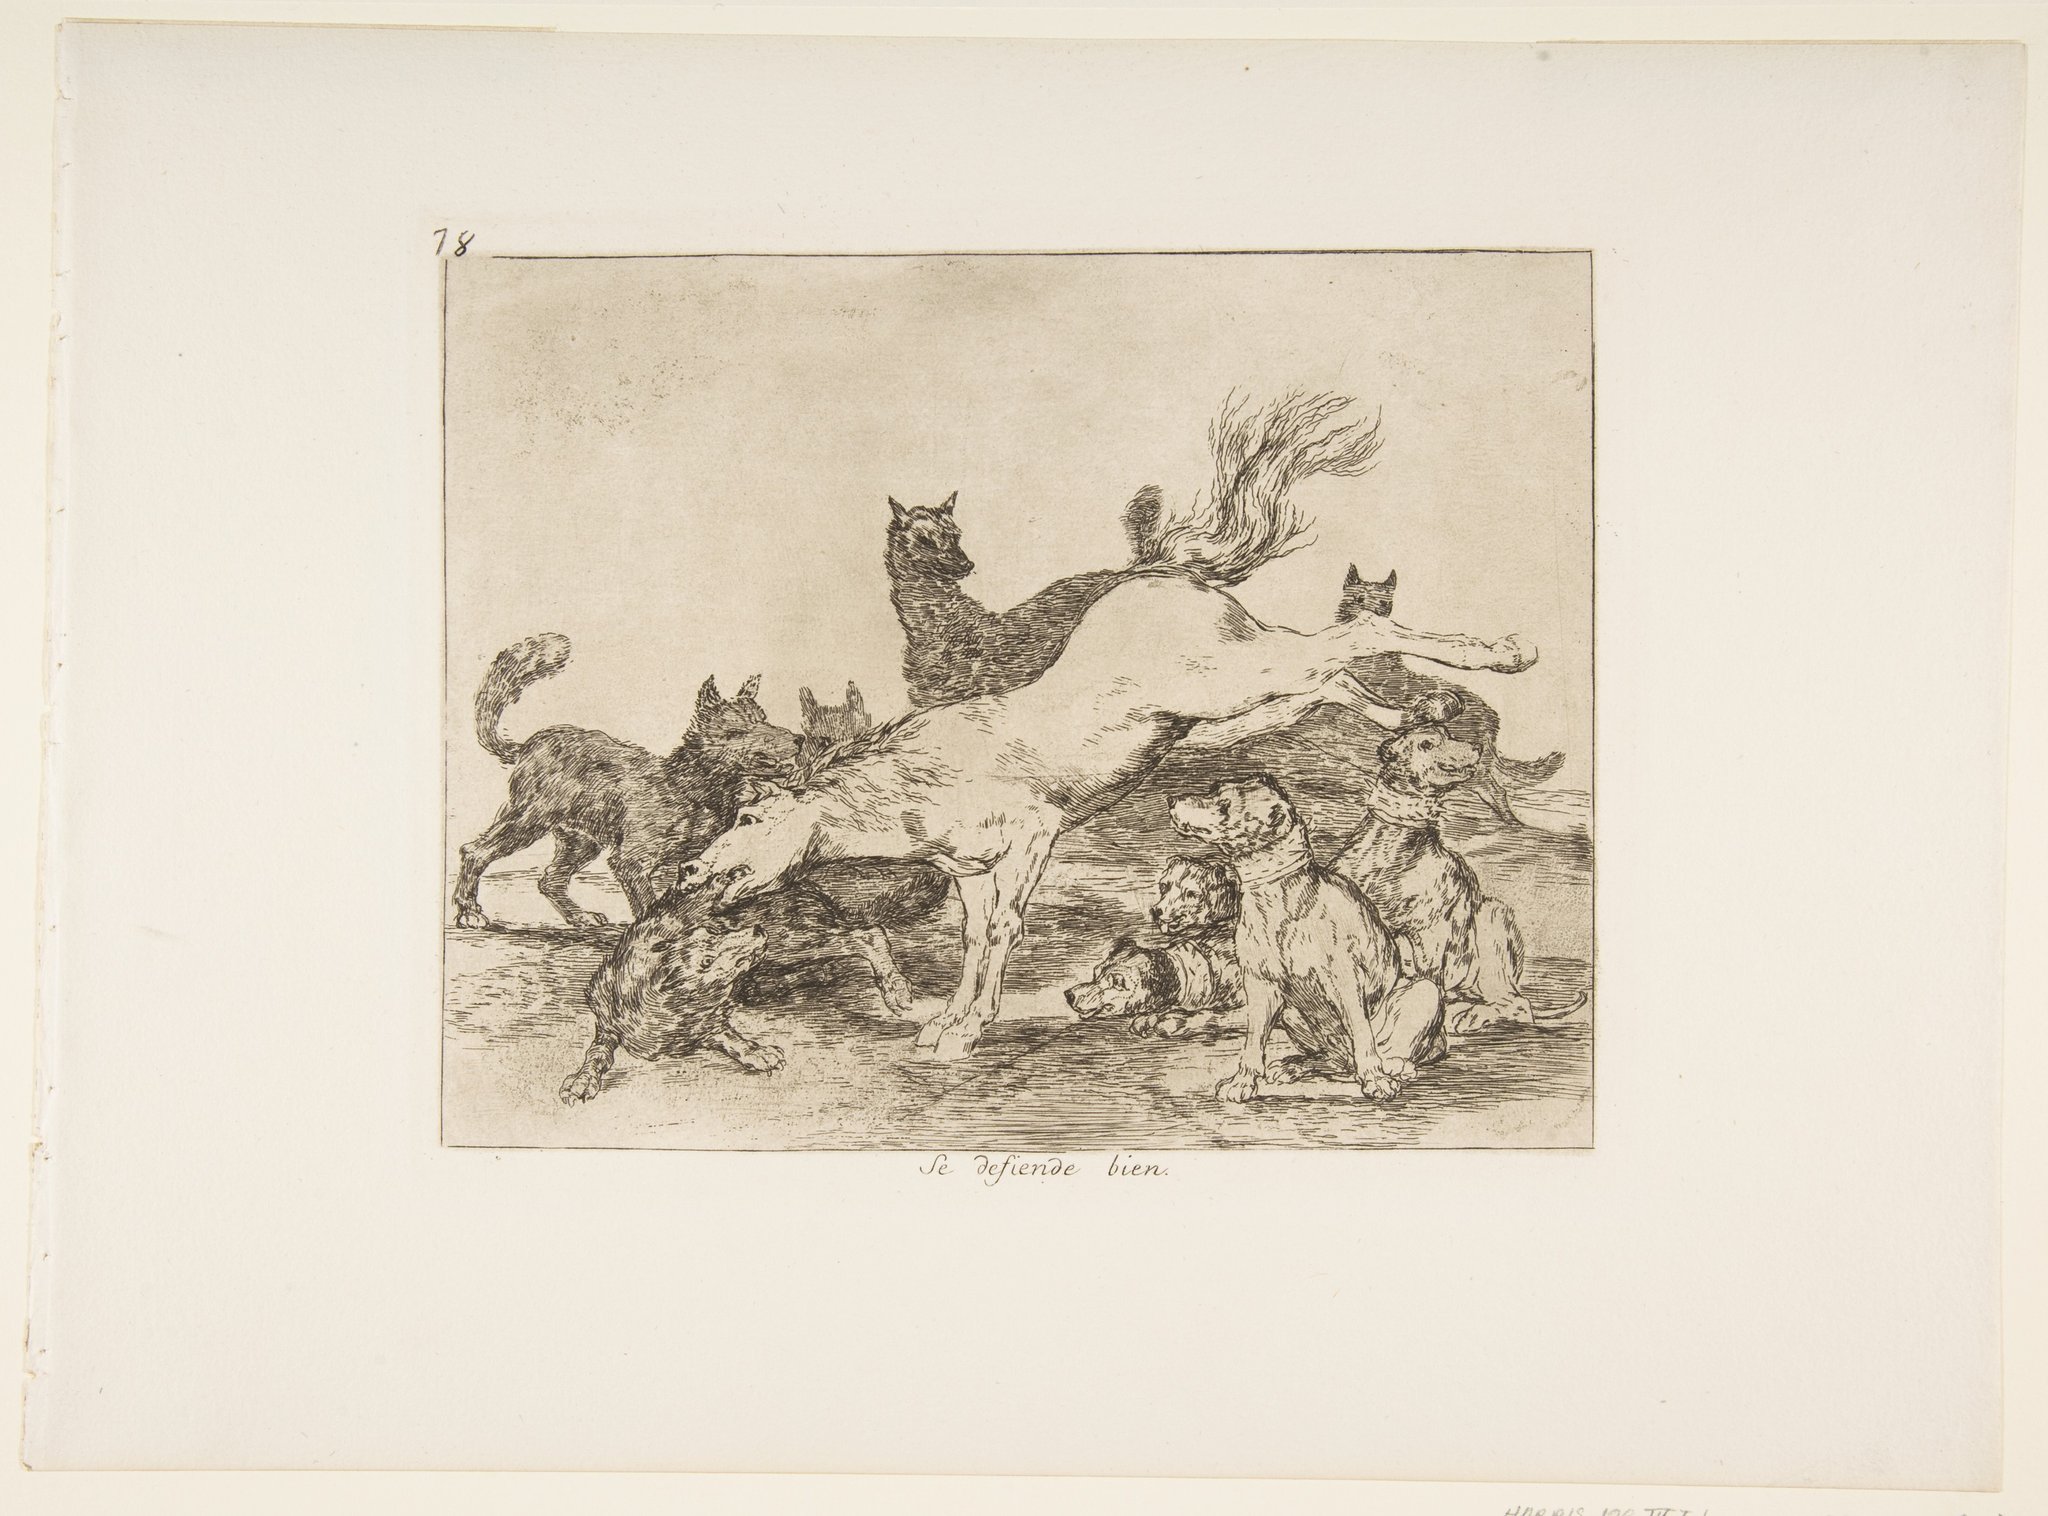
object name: print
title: Plate 78 from "The Disasters of War" (Los Desastres de la Guerra): 'He defends himself well' (Se defiende bien)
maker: goya (francisco de goya y lucientes)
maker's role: artist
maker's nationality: spanish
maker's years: 1746-1828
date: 1814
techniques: engraving, drypoint, etching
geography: spain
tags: dogs,horses